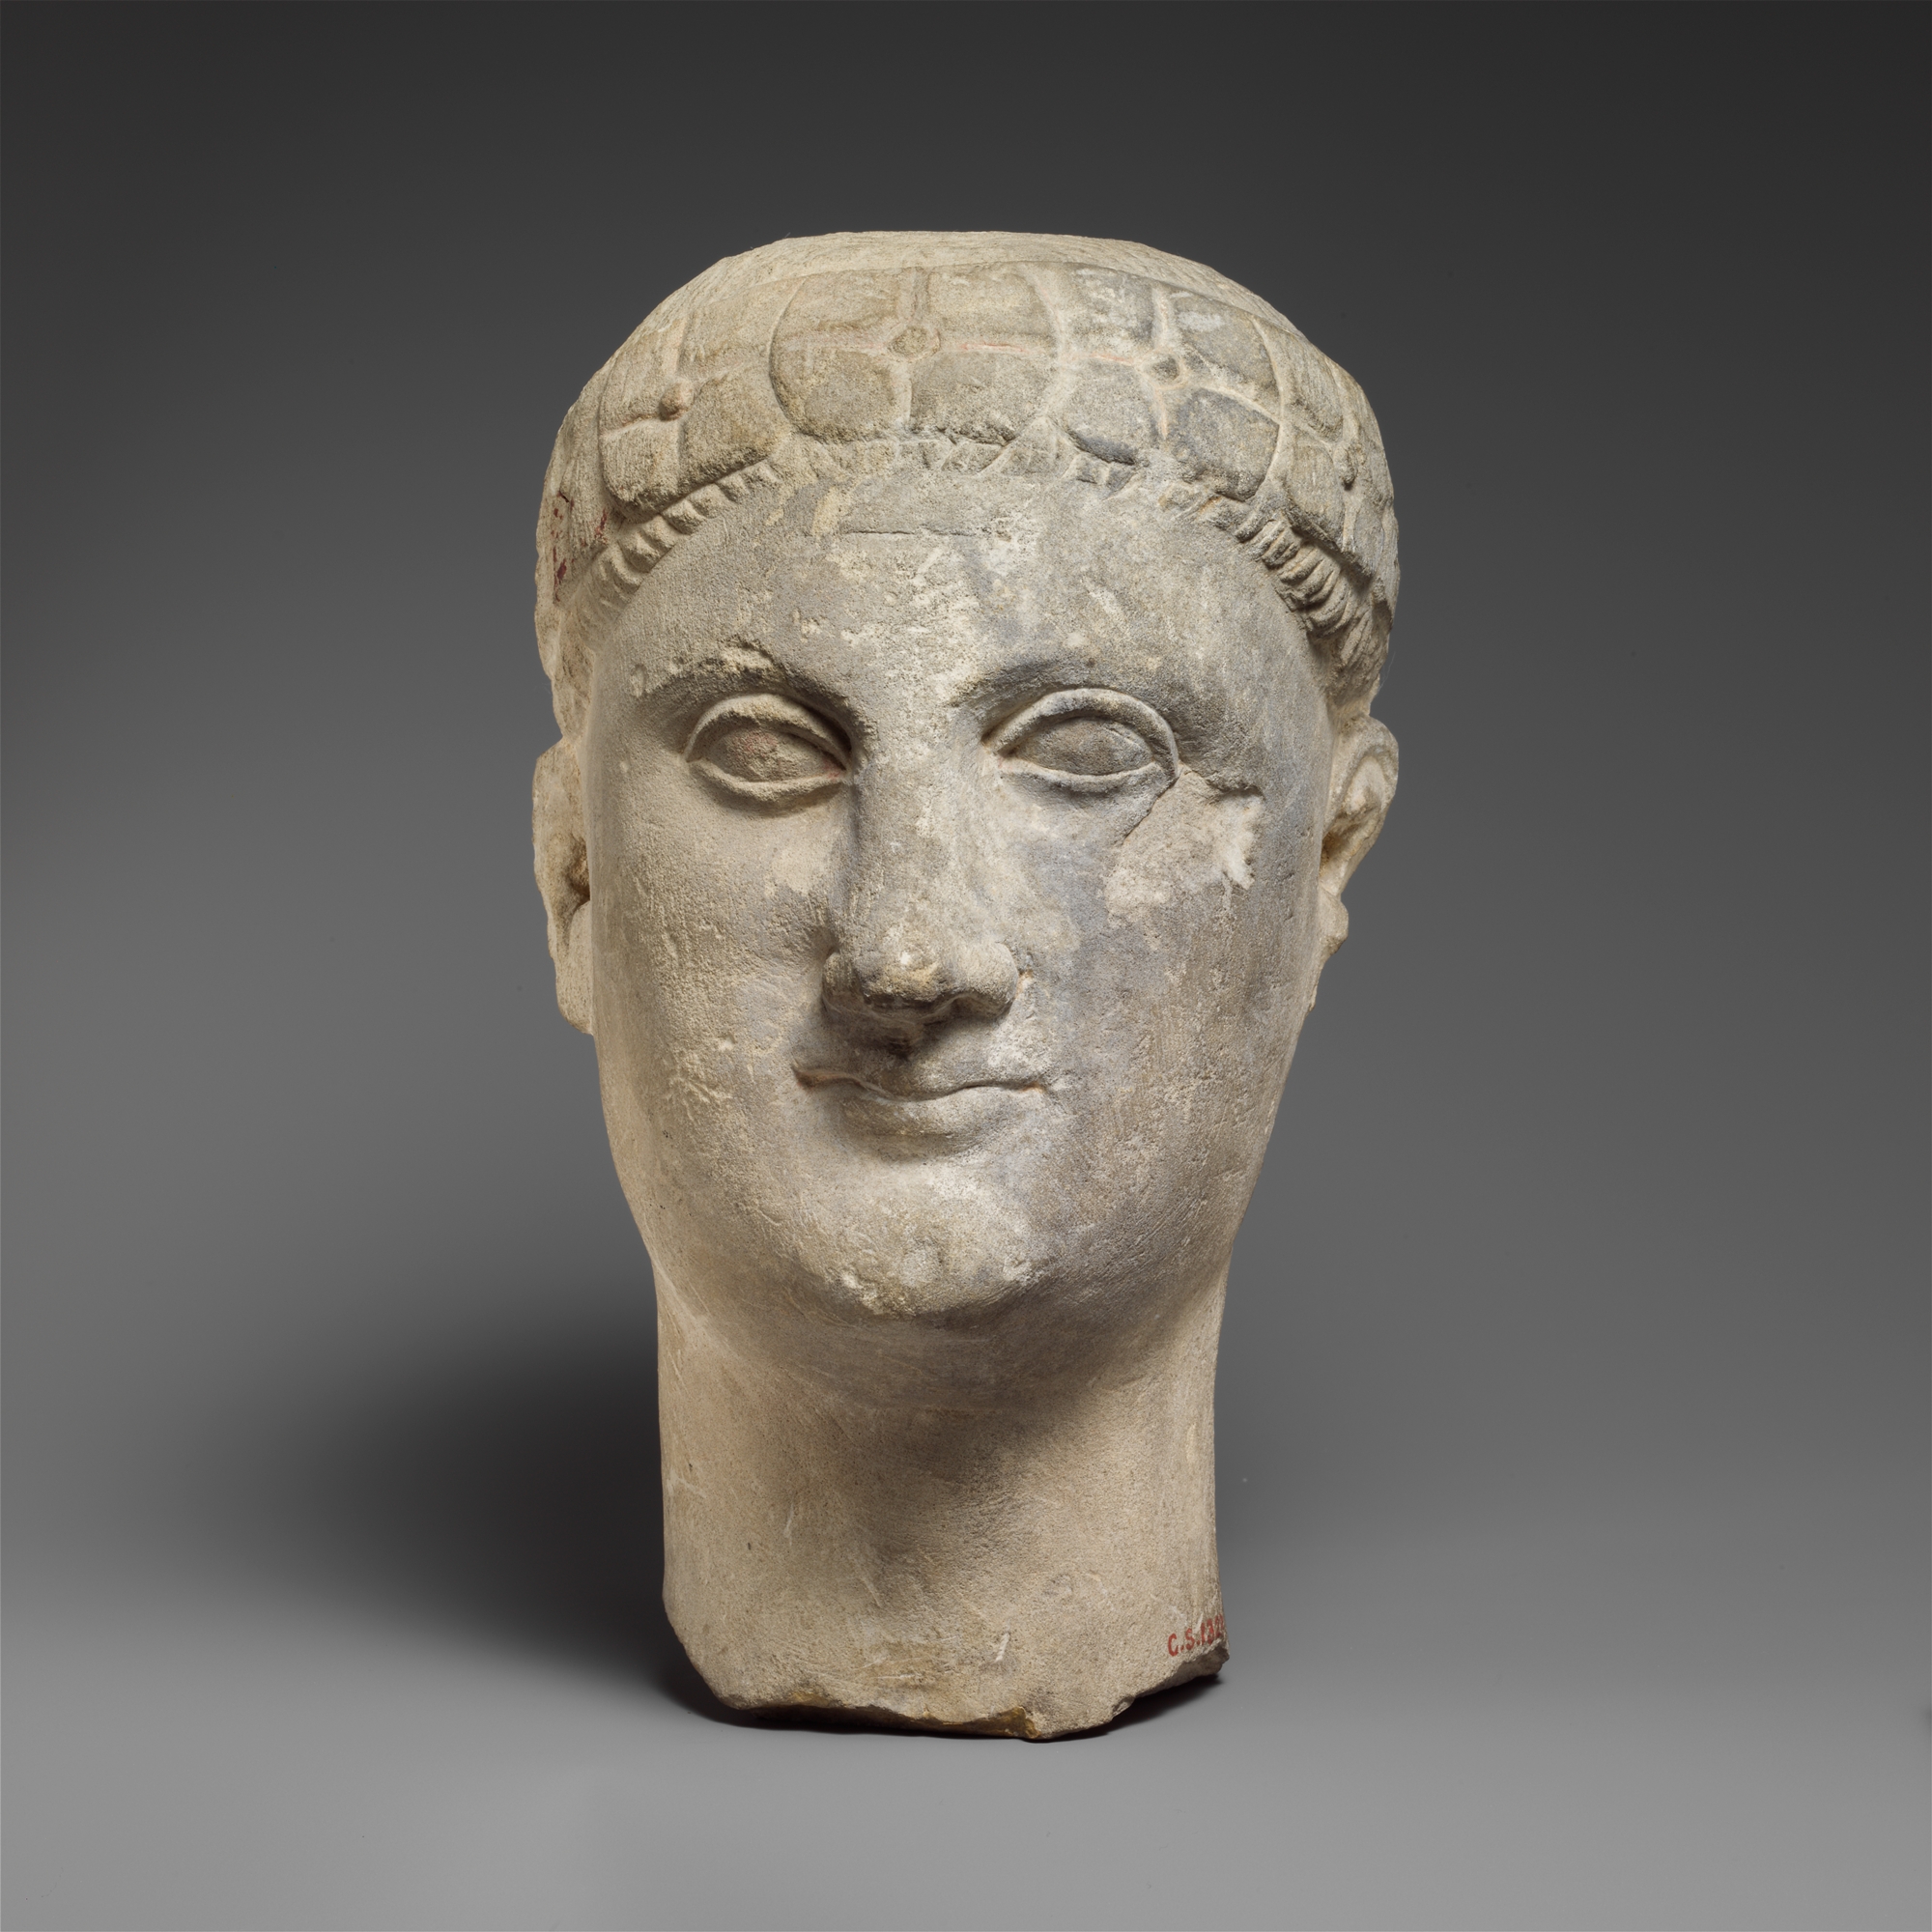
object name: head of a youth with wreath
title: Limestone male head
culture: roman, cypriot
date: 101-200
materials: limestone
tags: heads,men,wreaths